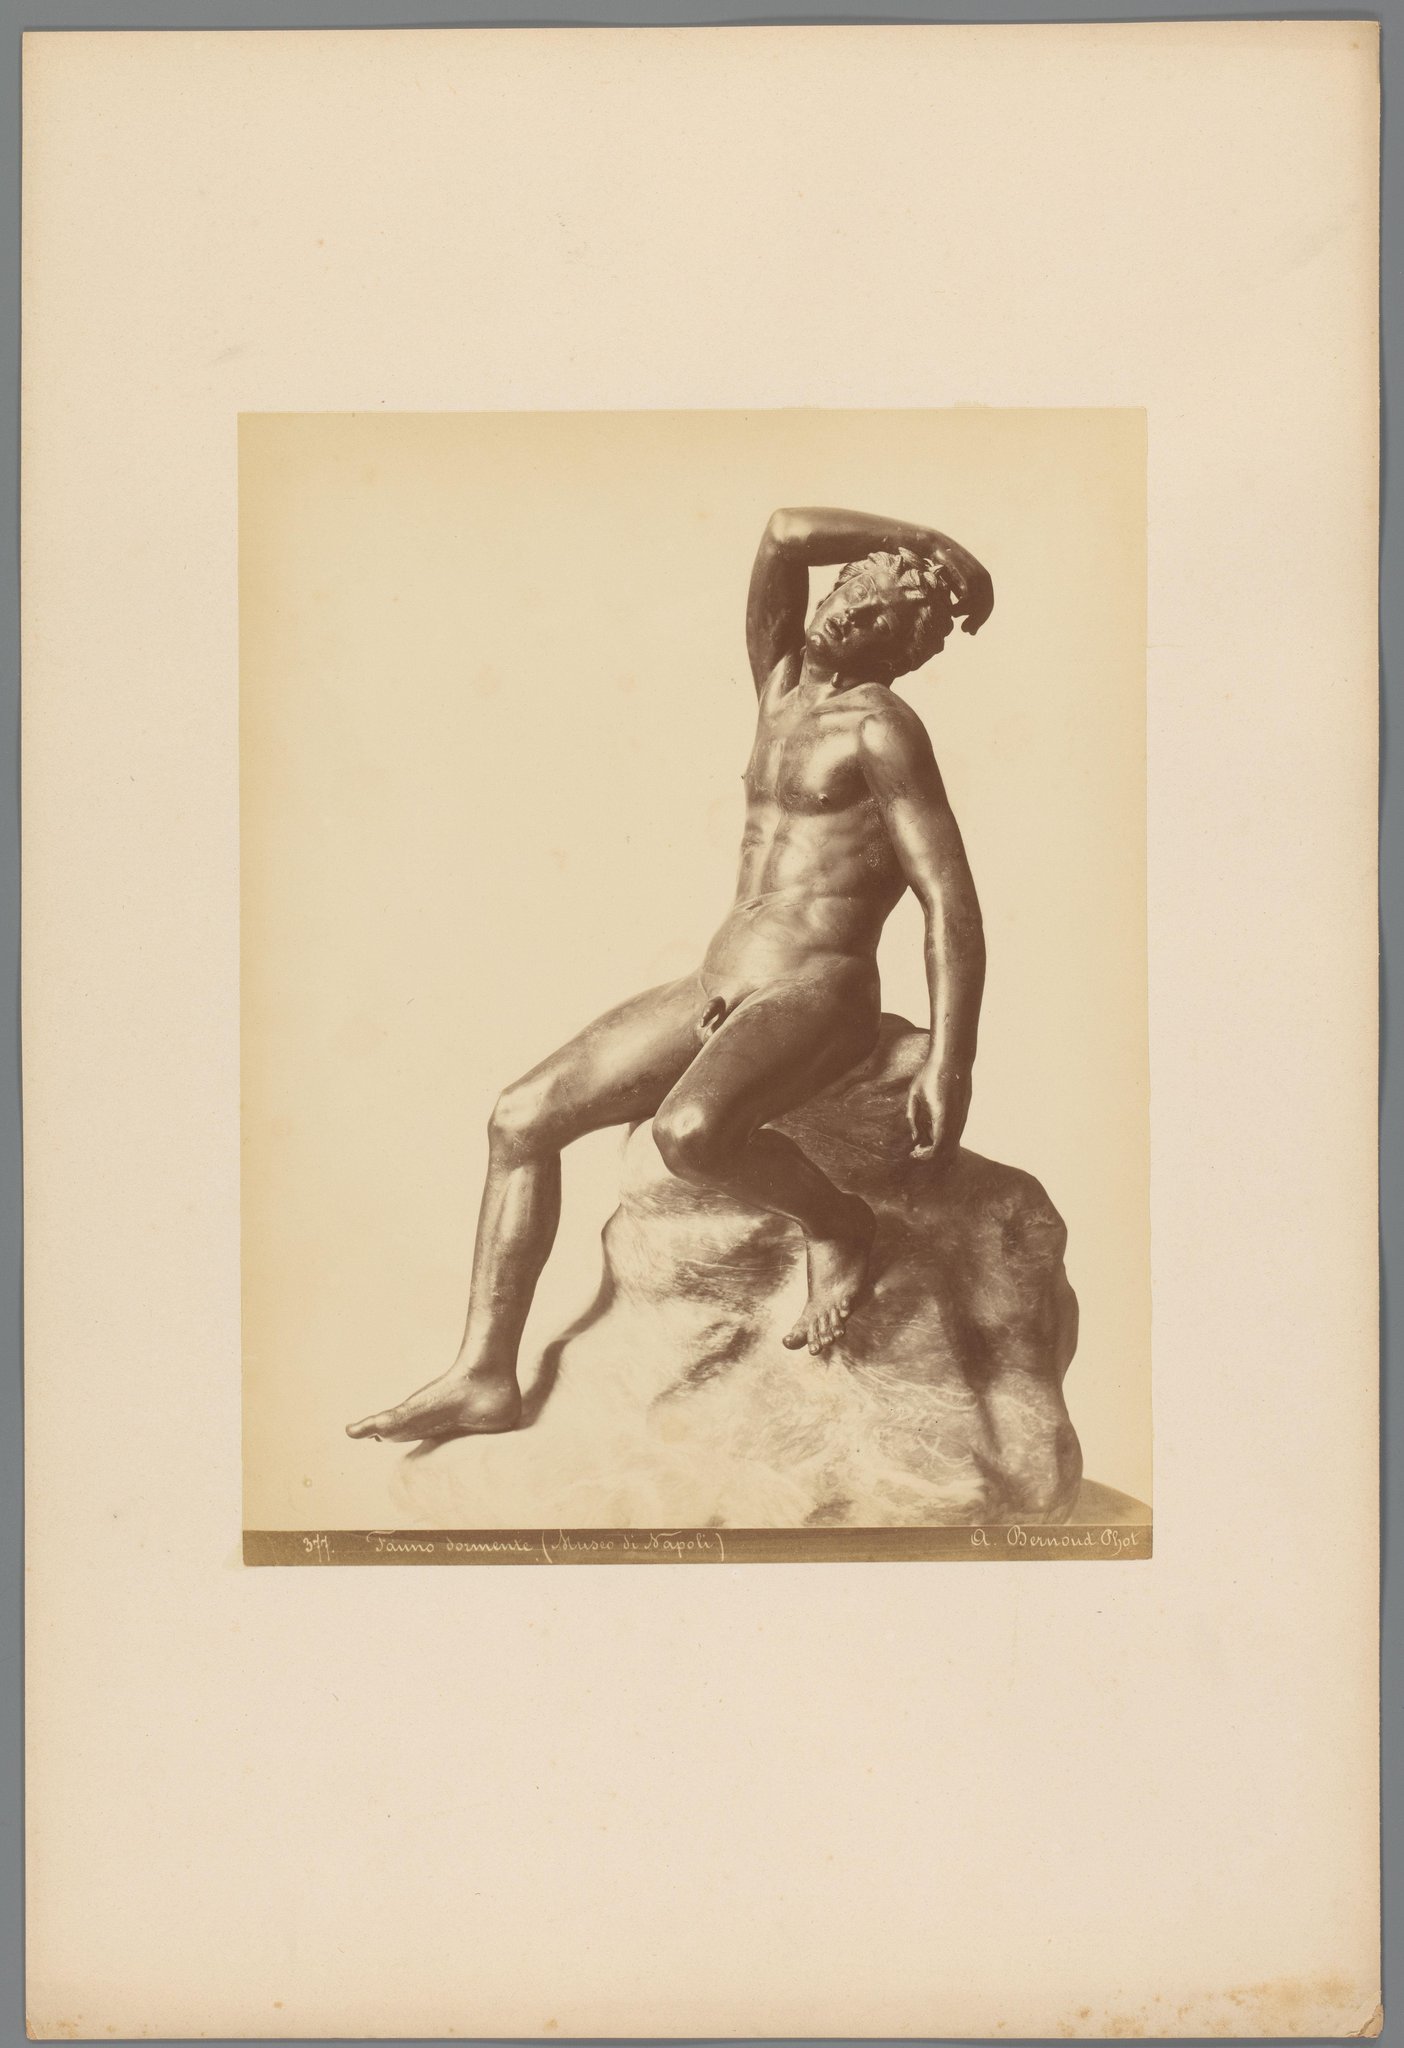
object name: photograph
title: Sculptuur van een zittende man op een rots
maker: alphonse bernoud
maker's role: fotograaf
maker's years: 1820-1889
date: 1851-1873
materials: cardboard, paper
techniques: albumen print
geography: naples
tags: piece of sculpture, reproduction of a piece of sculpture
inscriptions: number: ‘377.’